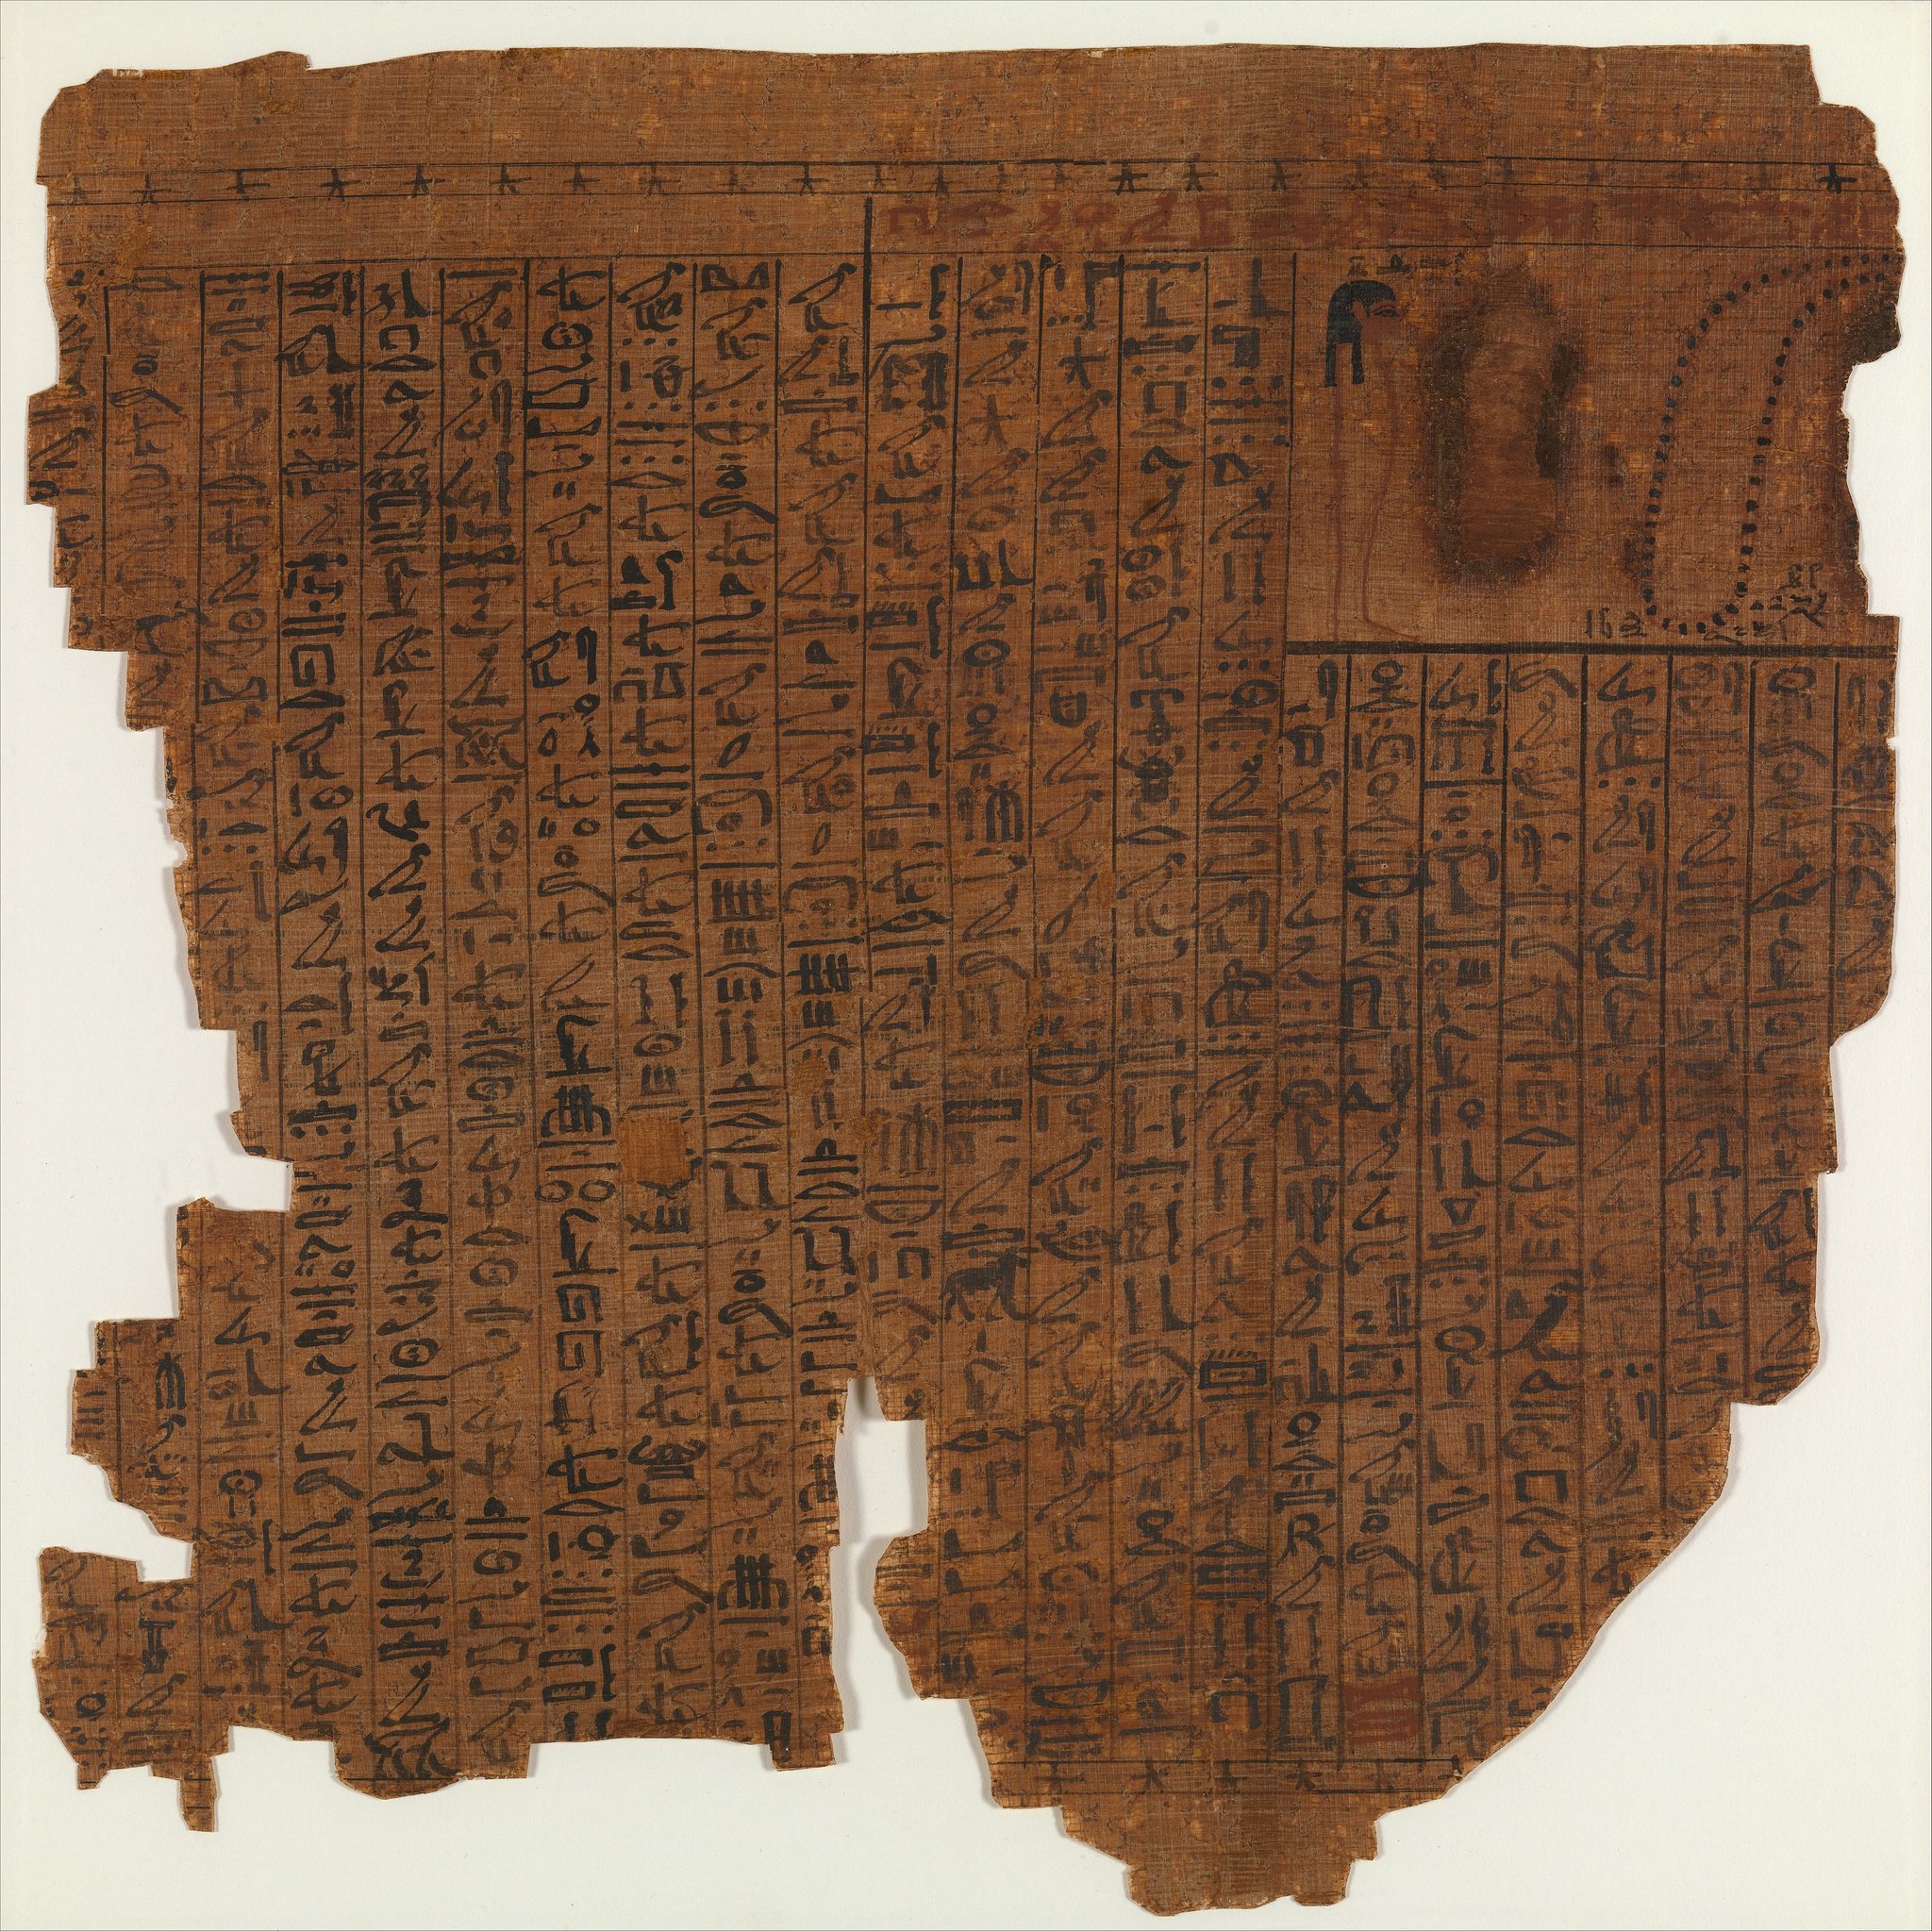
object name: papyrus, book of the dead, amenhotep, tt a 7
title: Sheet from the Papyrus of Amenhotep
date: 1427-1390 BCE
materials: ink, papyrus, pigment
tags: hieroglyphs